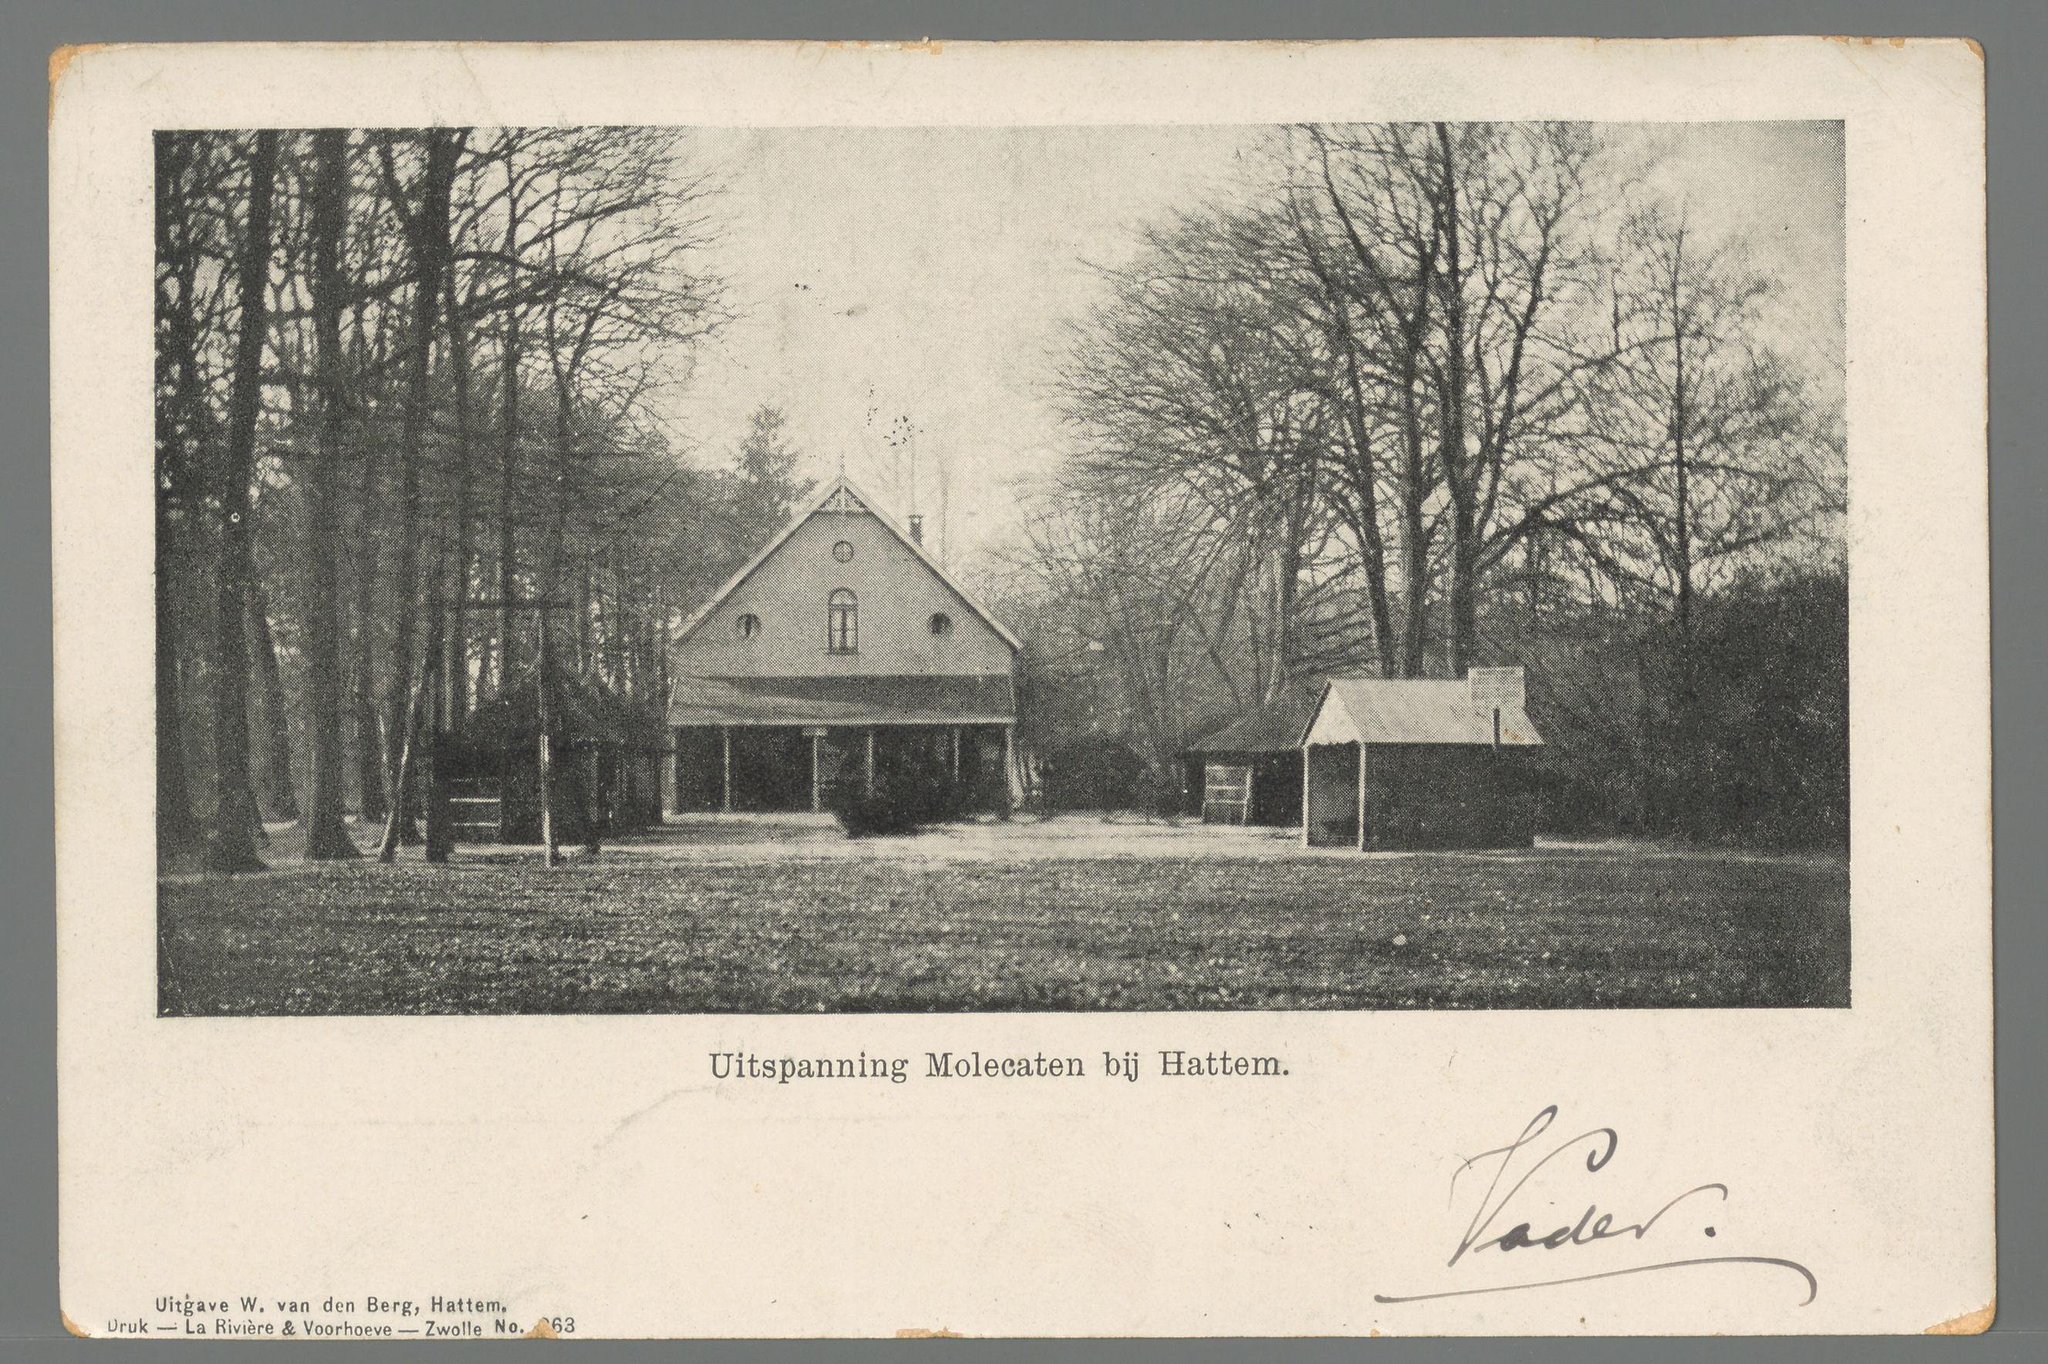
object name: ansichtkaart, prentbriefkaart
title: Uitspanning Molecaten bij Hattem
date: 1895-1901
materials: cardboard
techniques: writing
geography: hattem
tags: façade (of house or building)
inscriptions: postage stamp